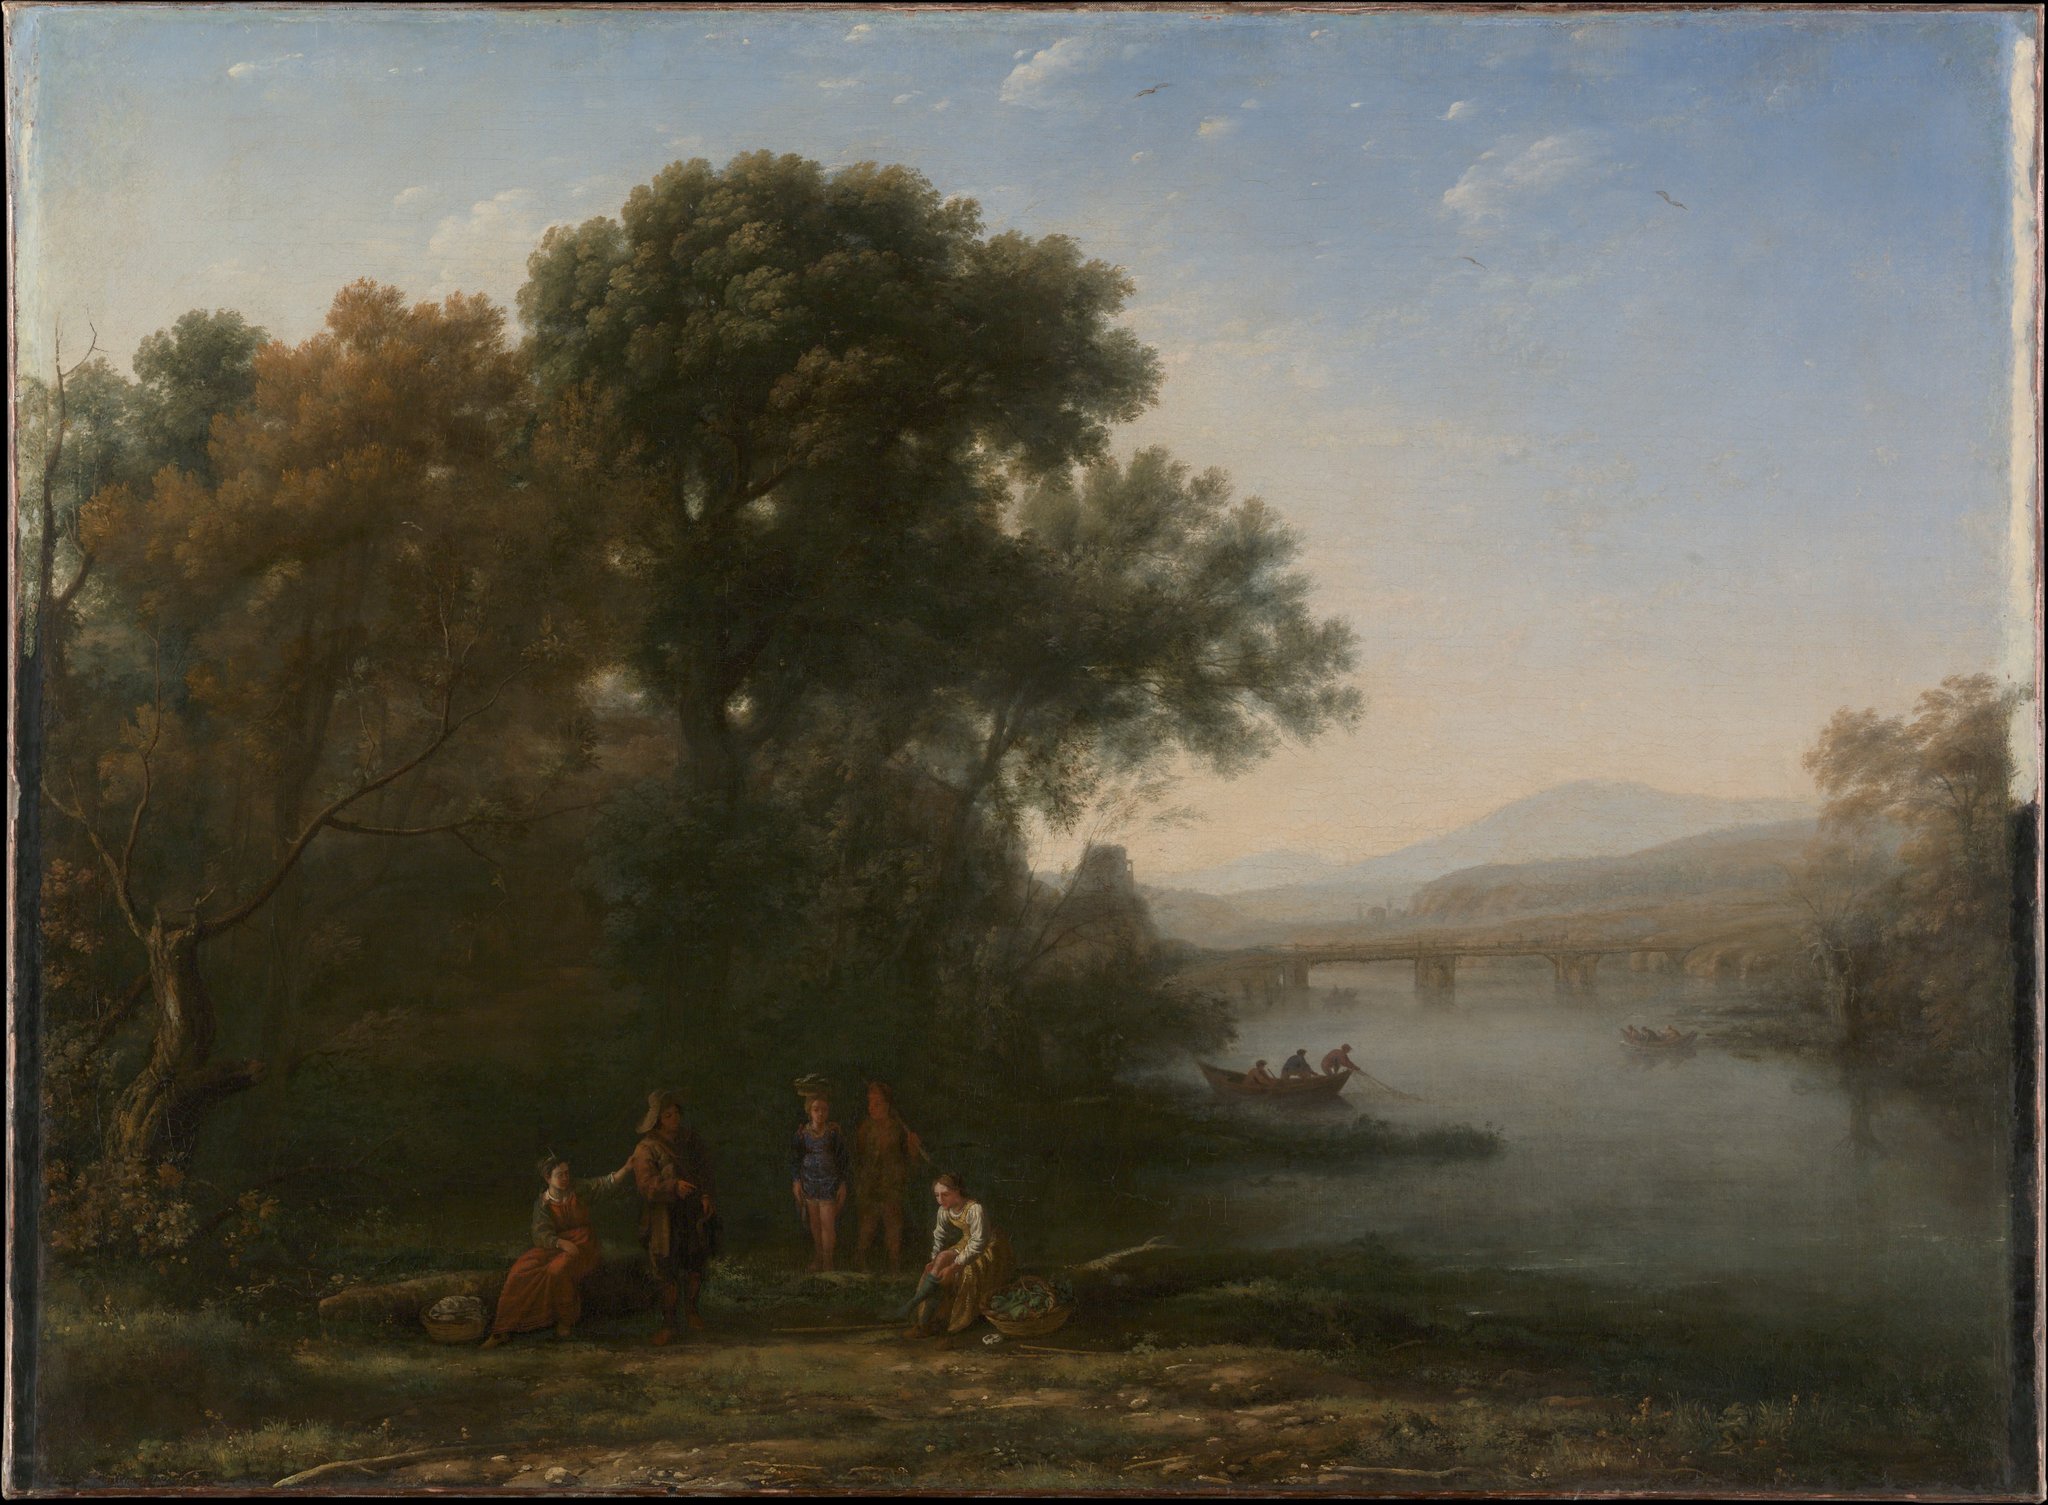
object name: painting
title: The Ford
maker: claude lorrain (claude gellée)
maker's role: artist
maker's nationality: french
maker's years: 1604-1682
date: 1636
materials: canvas, oil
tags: men,women,rivers,landscapes,boats